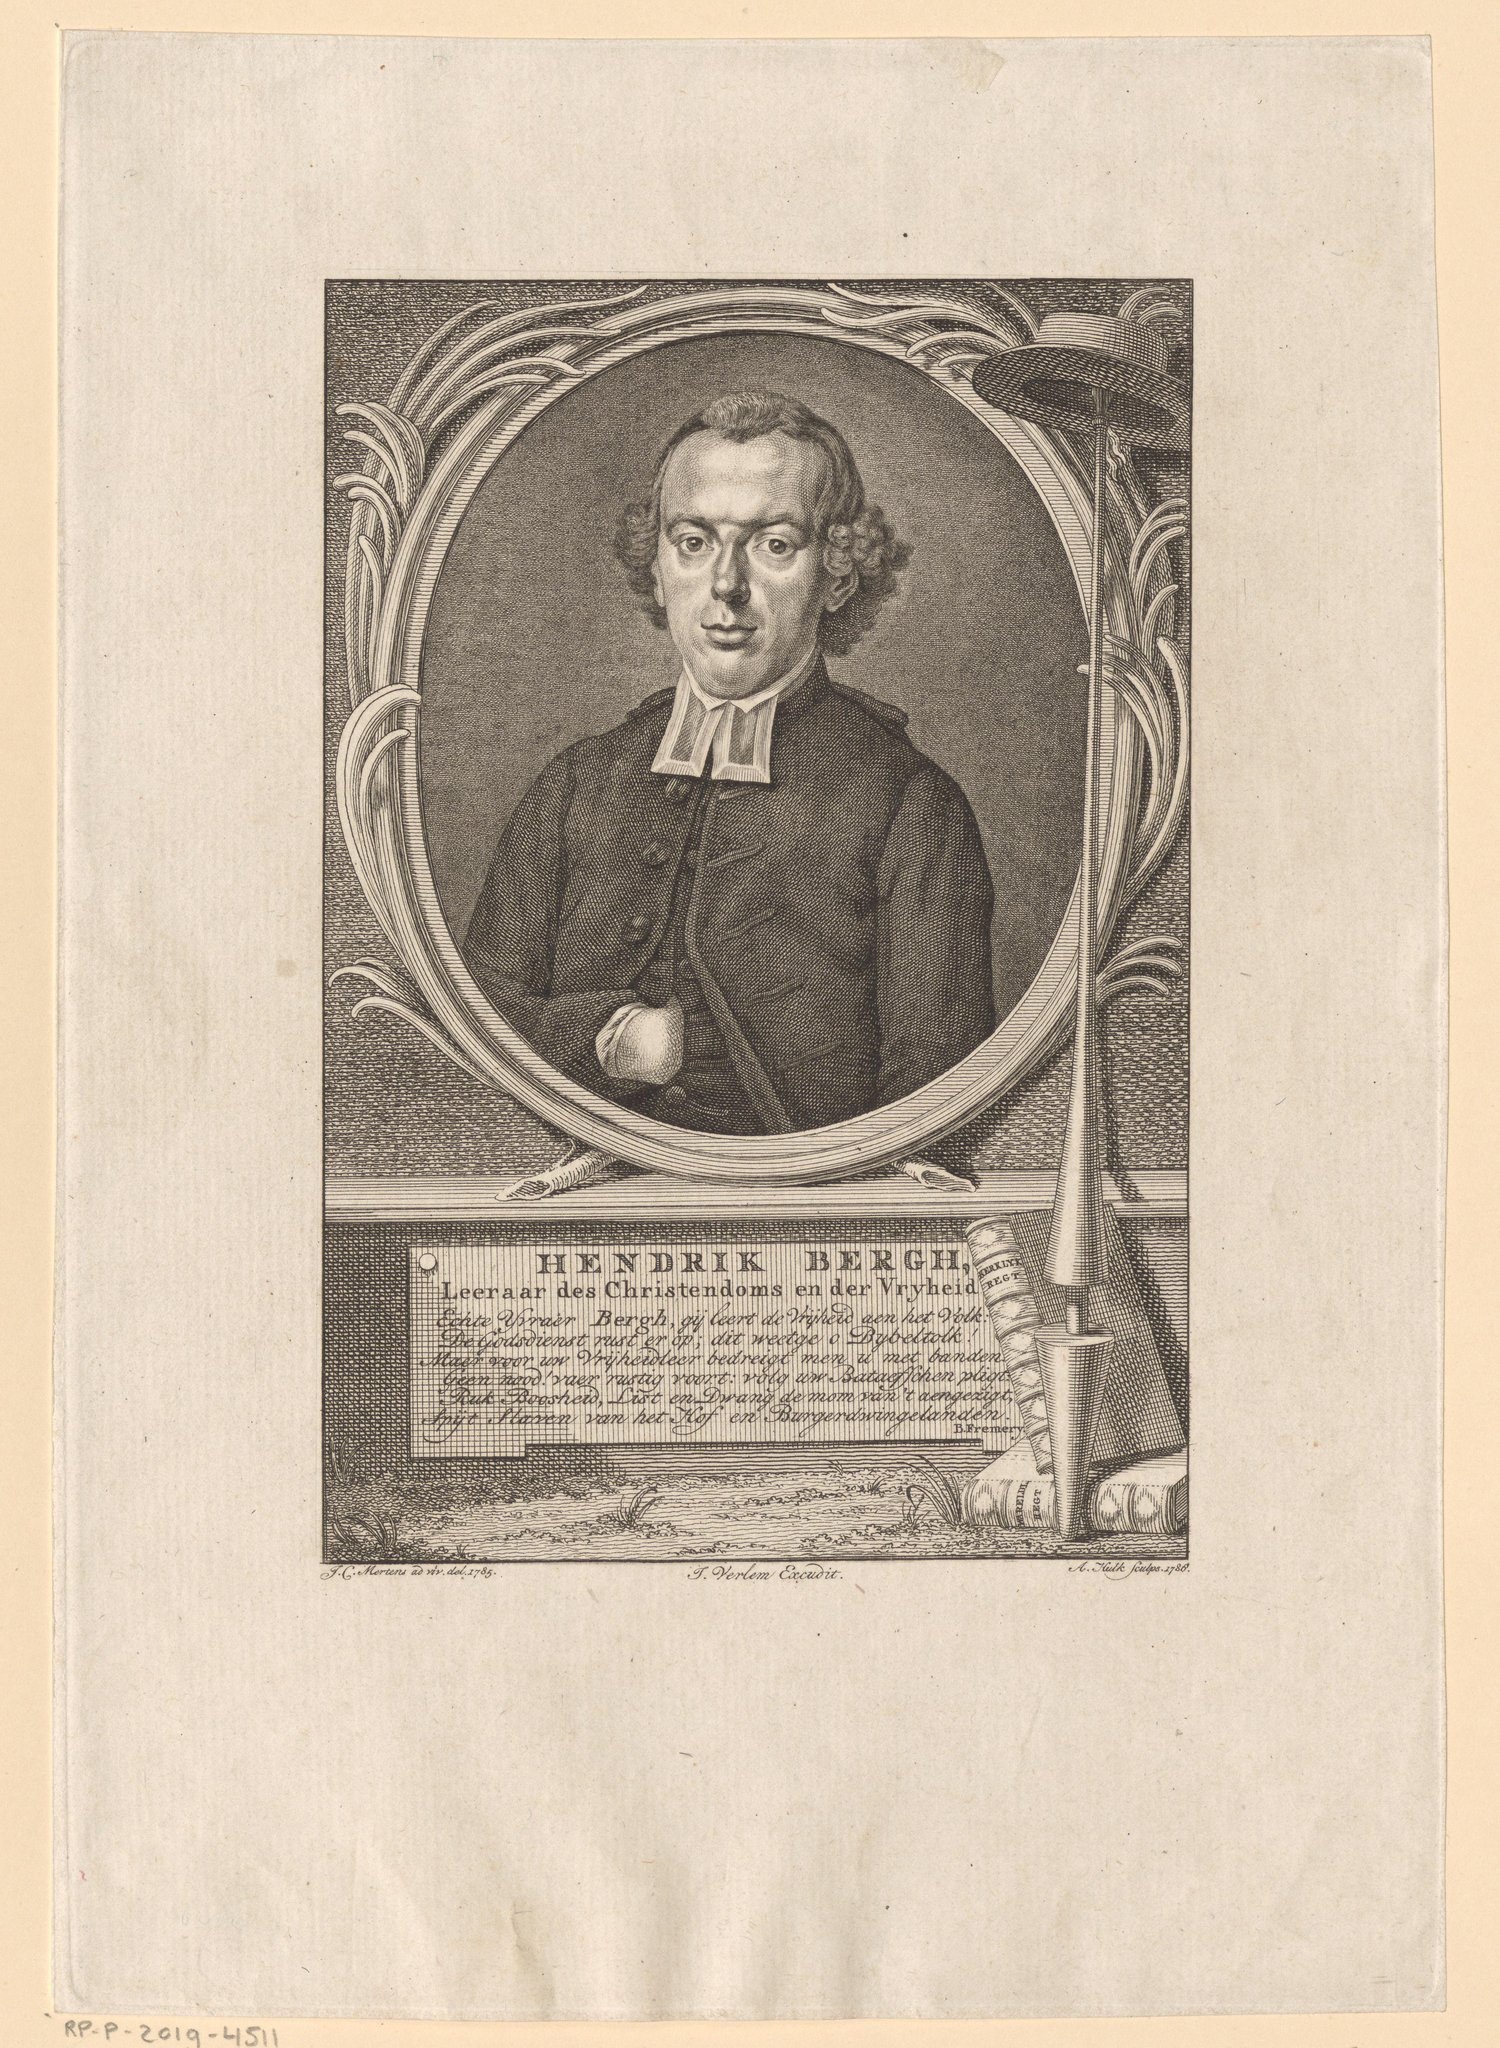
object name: print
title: Portret van Hendrik Bergh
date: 1786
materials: paper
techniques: engraving, etching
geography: amsterdam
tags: historical persons, head-gear: hat, book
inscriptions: date